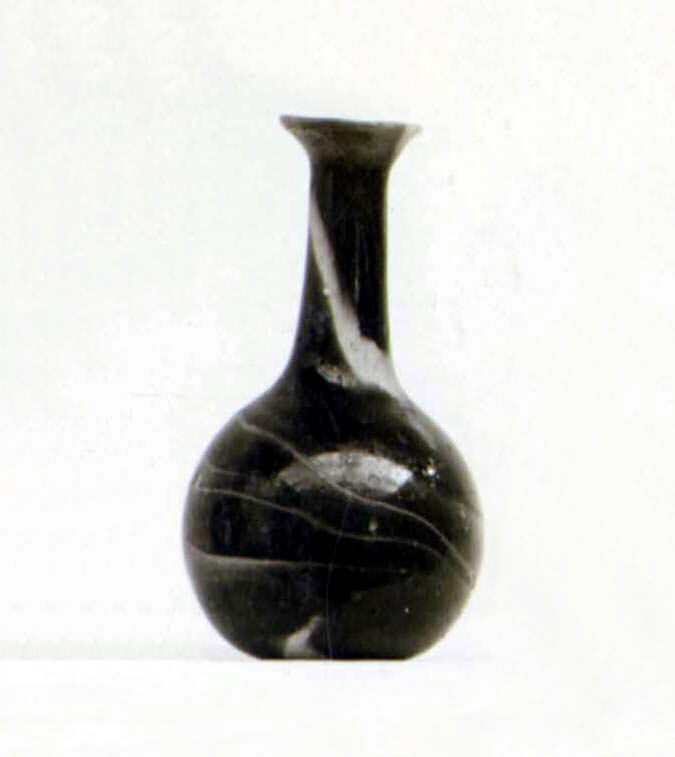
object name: perfume bottle, mosaic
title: Glass mosaic perfume bottle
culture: roman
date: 1-50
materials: glass